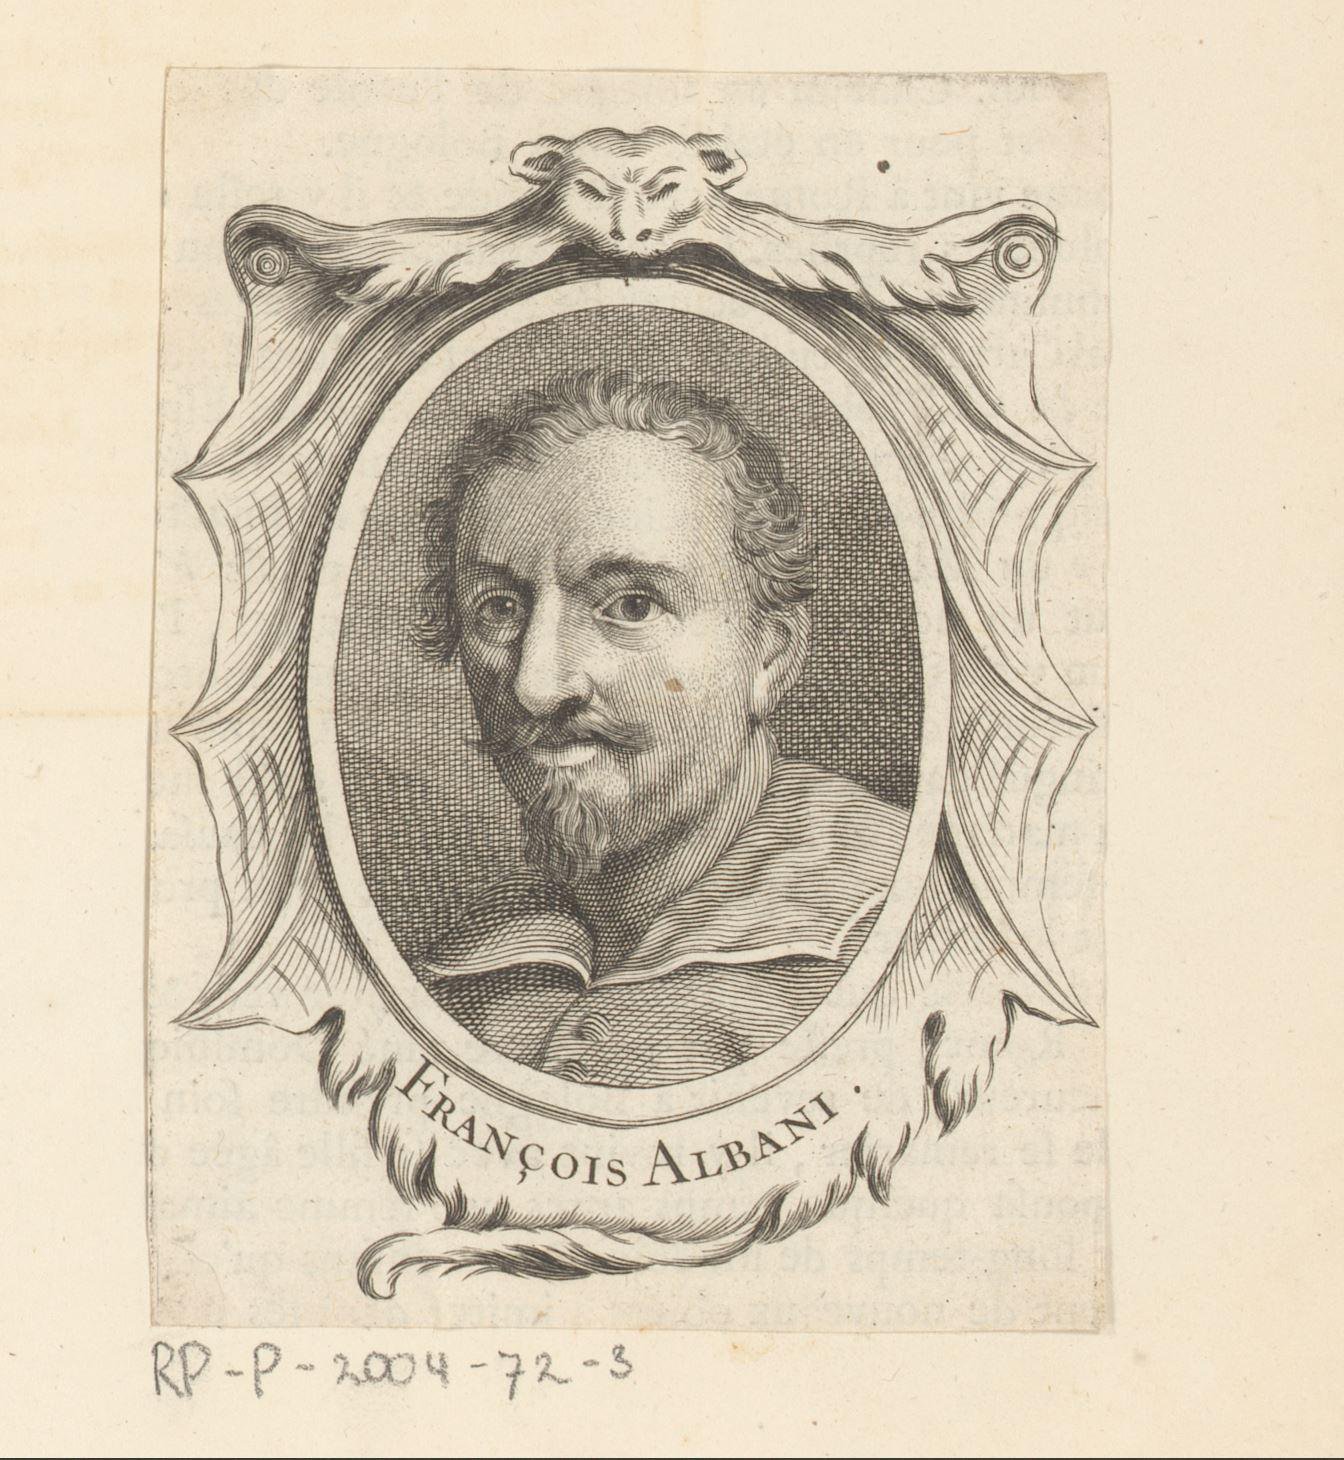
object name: album leaf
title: Portret van Francesco Albani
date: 1745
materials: paper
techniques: engraving, letterpress printing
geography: paris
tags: painter, draughtsman, francesco albani, historical persons, portrait, self-portrait of painter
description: Prent uit: Dézallier d'Argenville, Antoine Joseph. Abrégé de la vie des plus fameux peintres. 4 dln. Parijs: De Bure l'aîné, 1745, dl. 1, p. 285. De samensteller heeft deze prent in het album geplakt als illustratie bij: Pilkington, Matthew en Johann Heinrich Füssli. A dictionary of painters, from the revival of the art to the present period. 4 dln. Londen: John Crowder, 1805, dl. 1, p. 4.